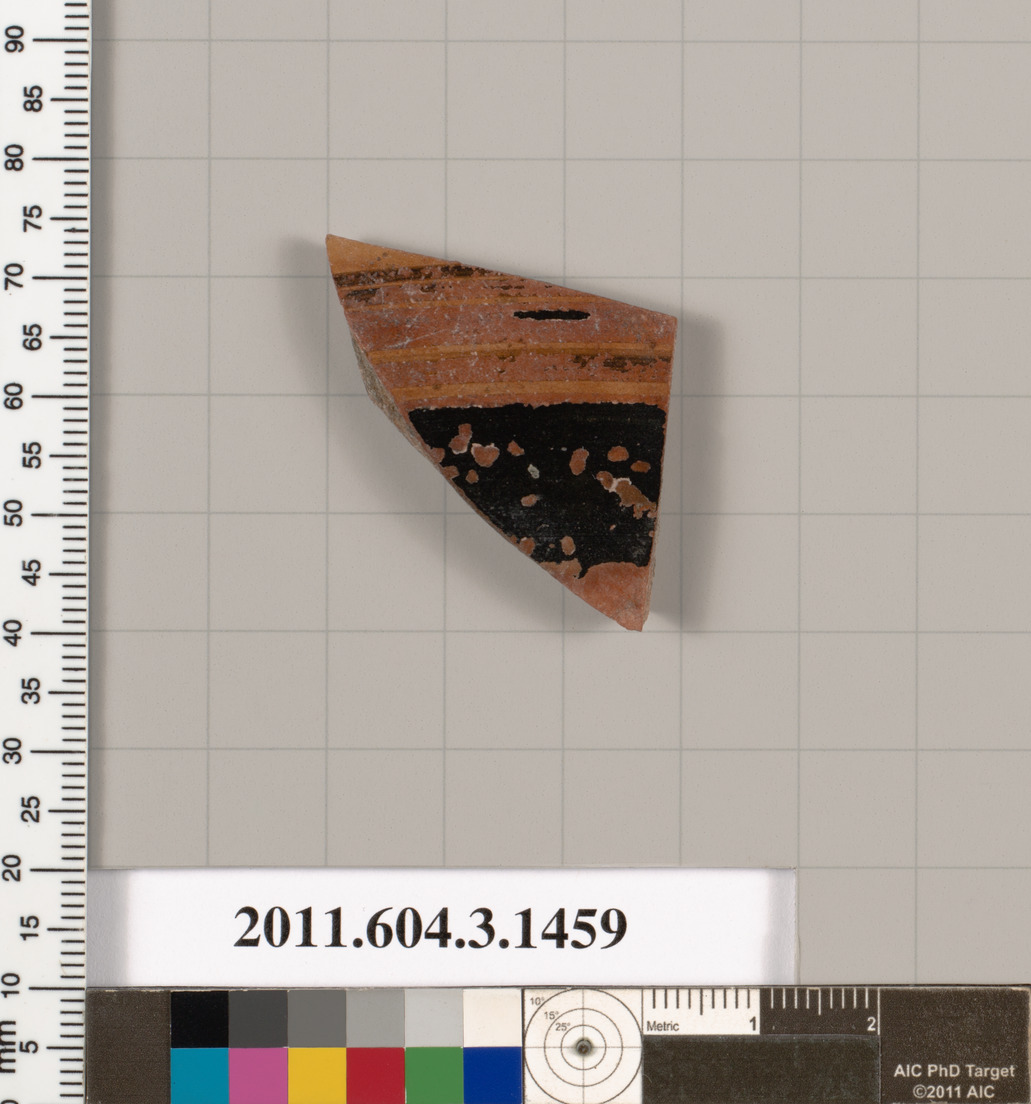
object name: skyphos fragment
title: Terracotta fragment of a skyphos (deep drinking cup)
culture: greek, attic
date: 600-401 BCE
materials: terracotta